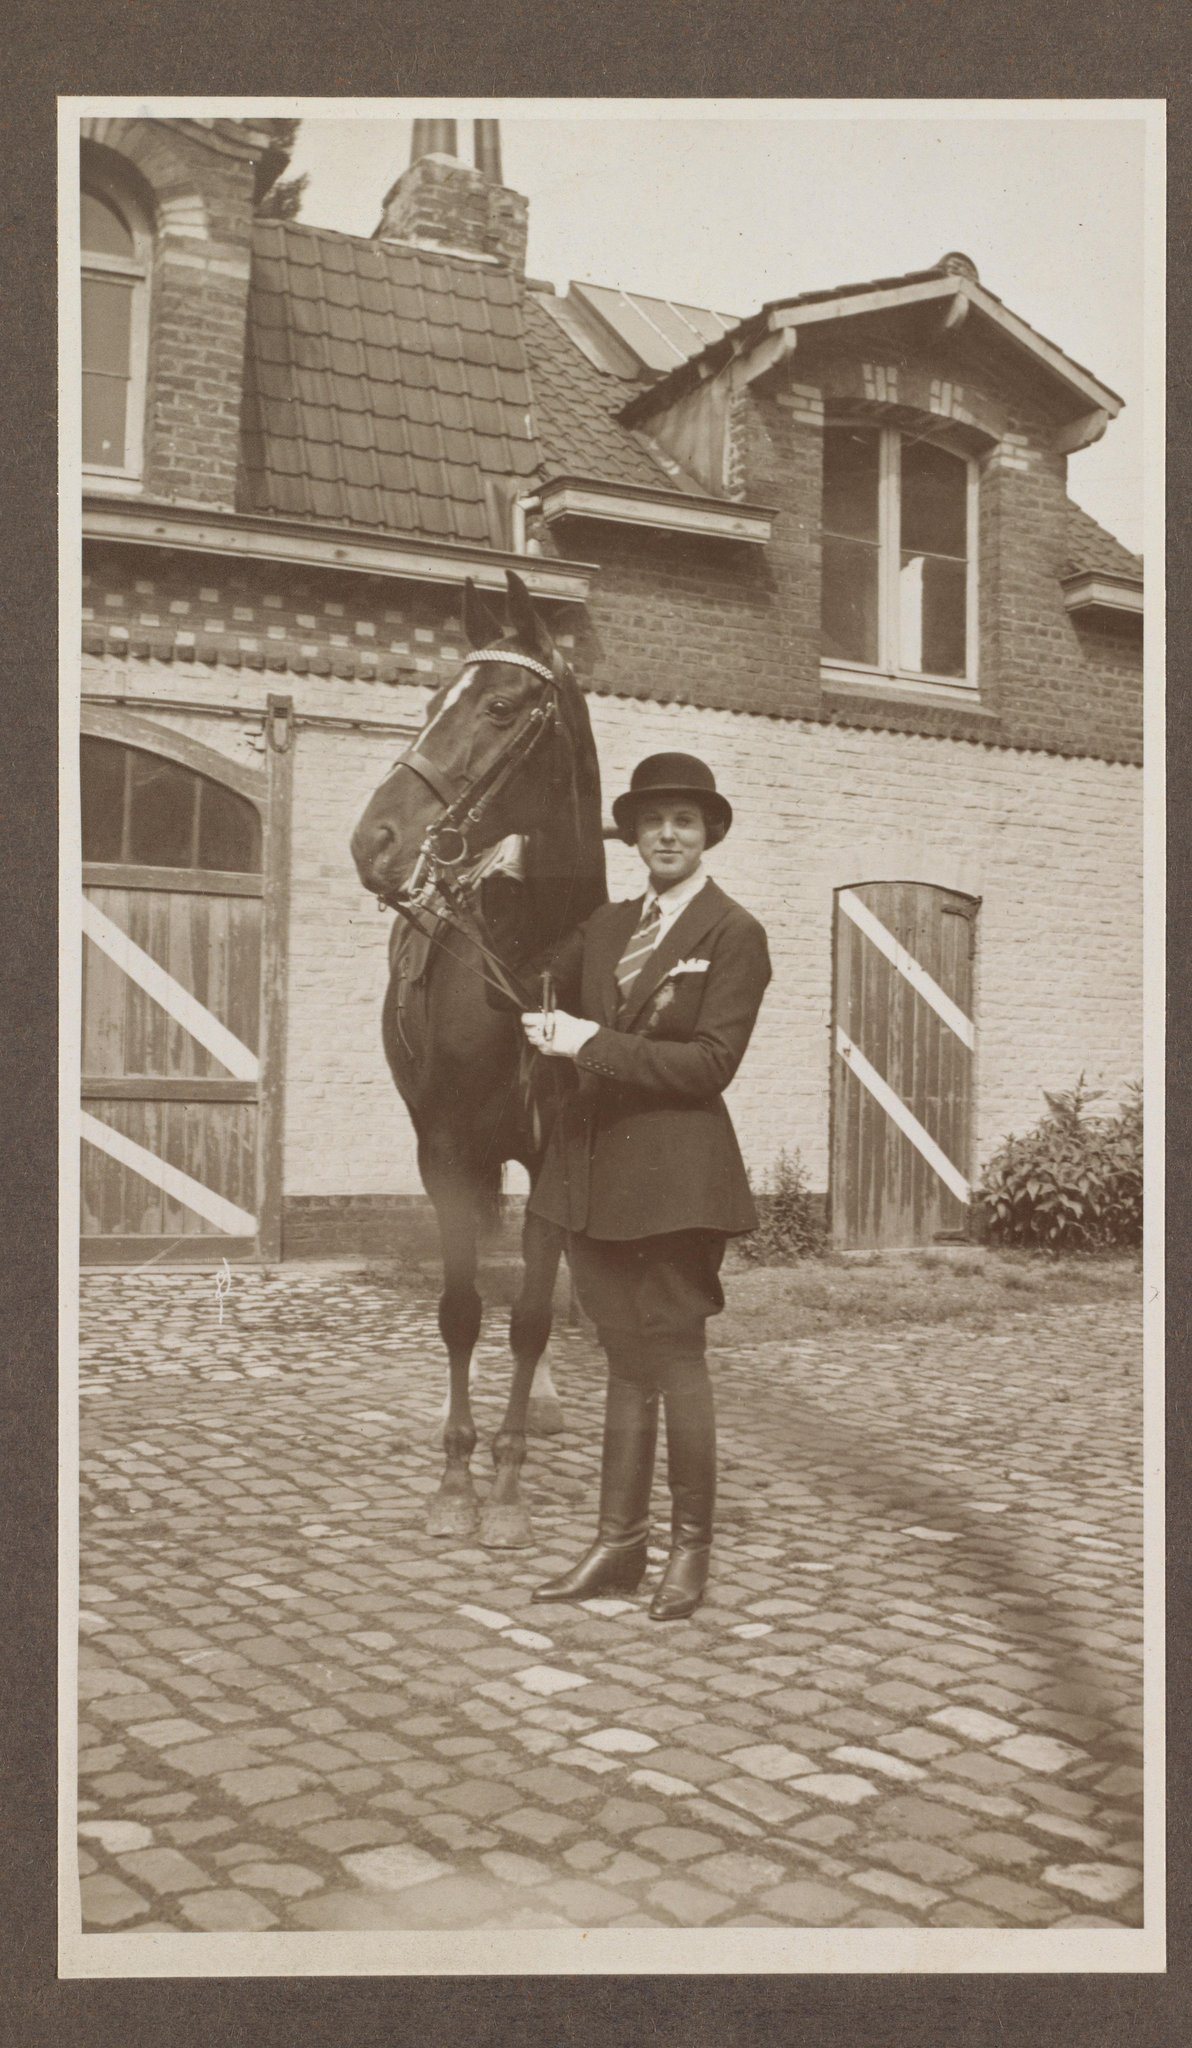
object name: album leaf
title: G.A. Urtebise in amazonekostuum staand bij een paard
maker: Anonymous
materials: cardboard, photographic support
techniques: gelatin silver print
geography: belgium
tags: amsterdam, riding a horse, ass, or mule; rider, horseman, fashion, clothing, adolescent, young woman, maiden, horse, belgium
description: Onderdeel van Fotoalbum van G.A. Urtebise in amazonekostuum.